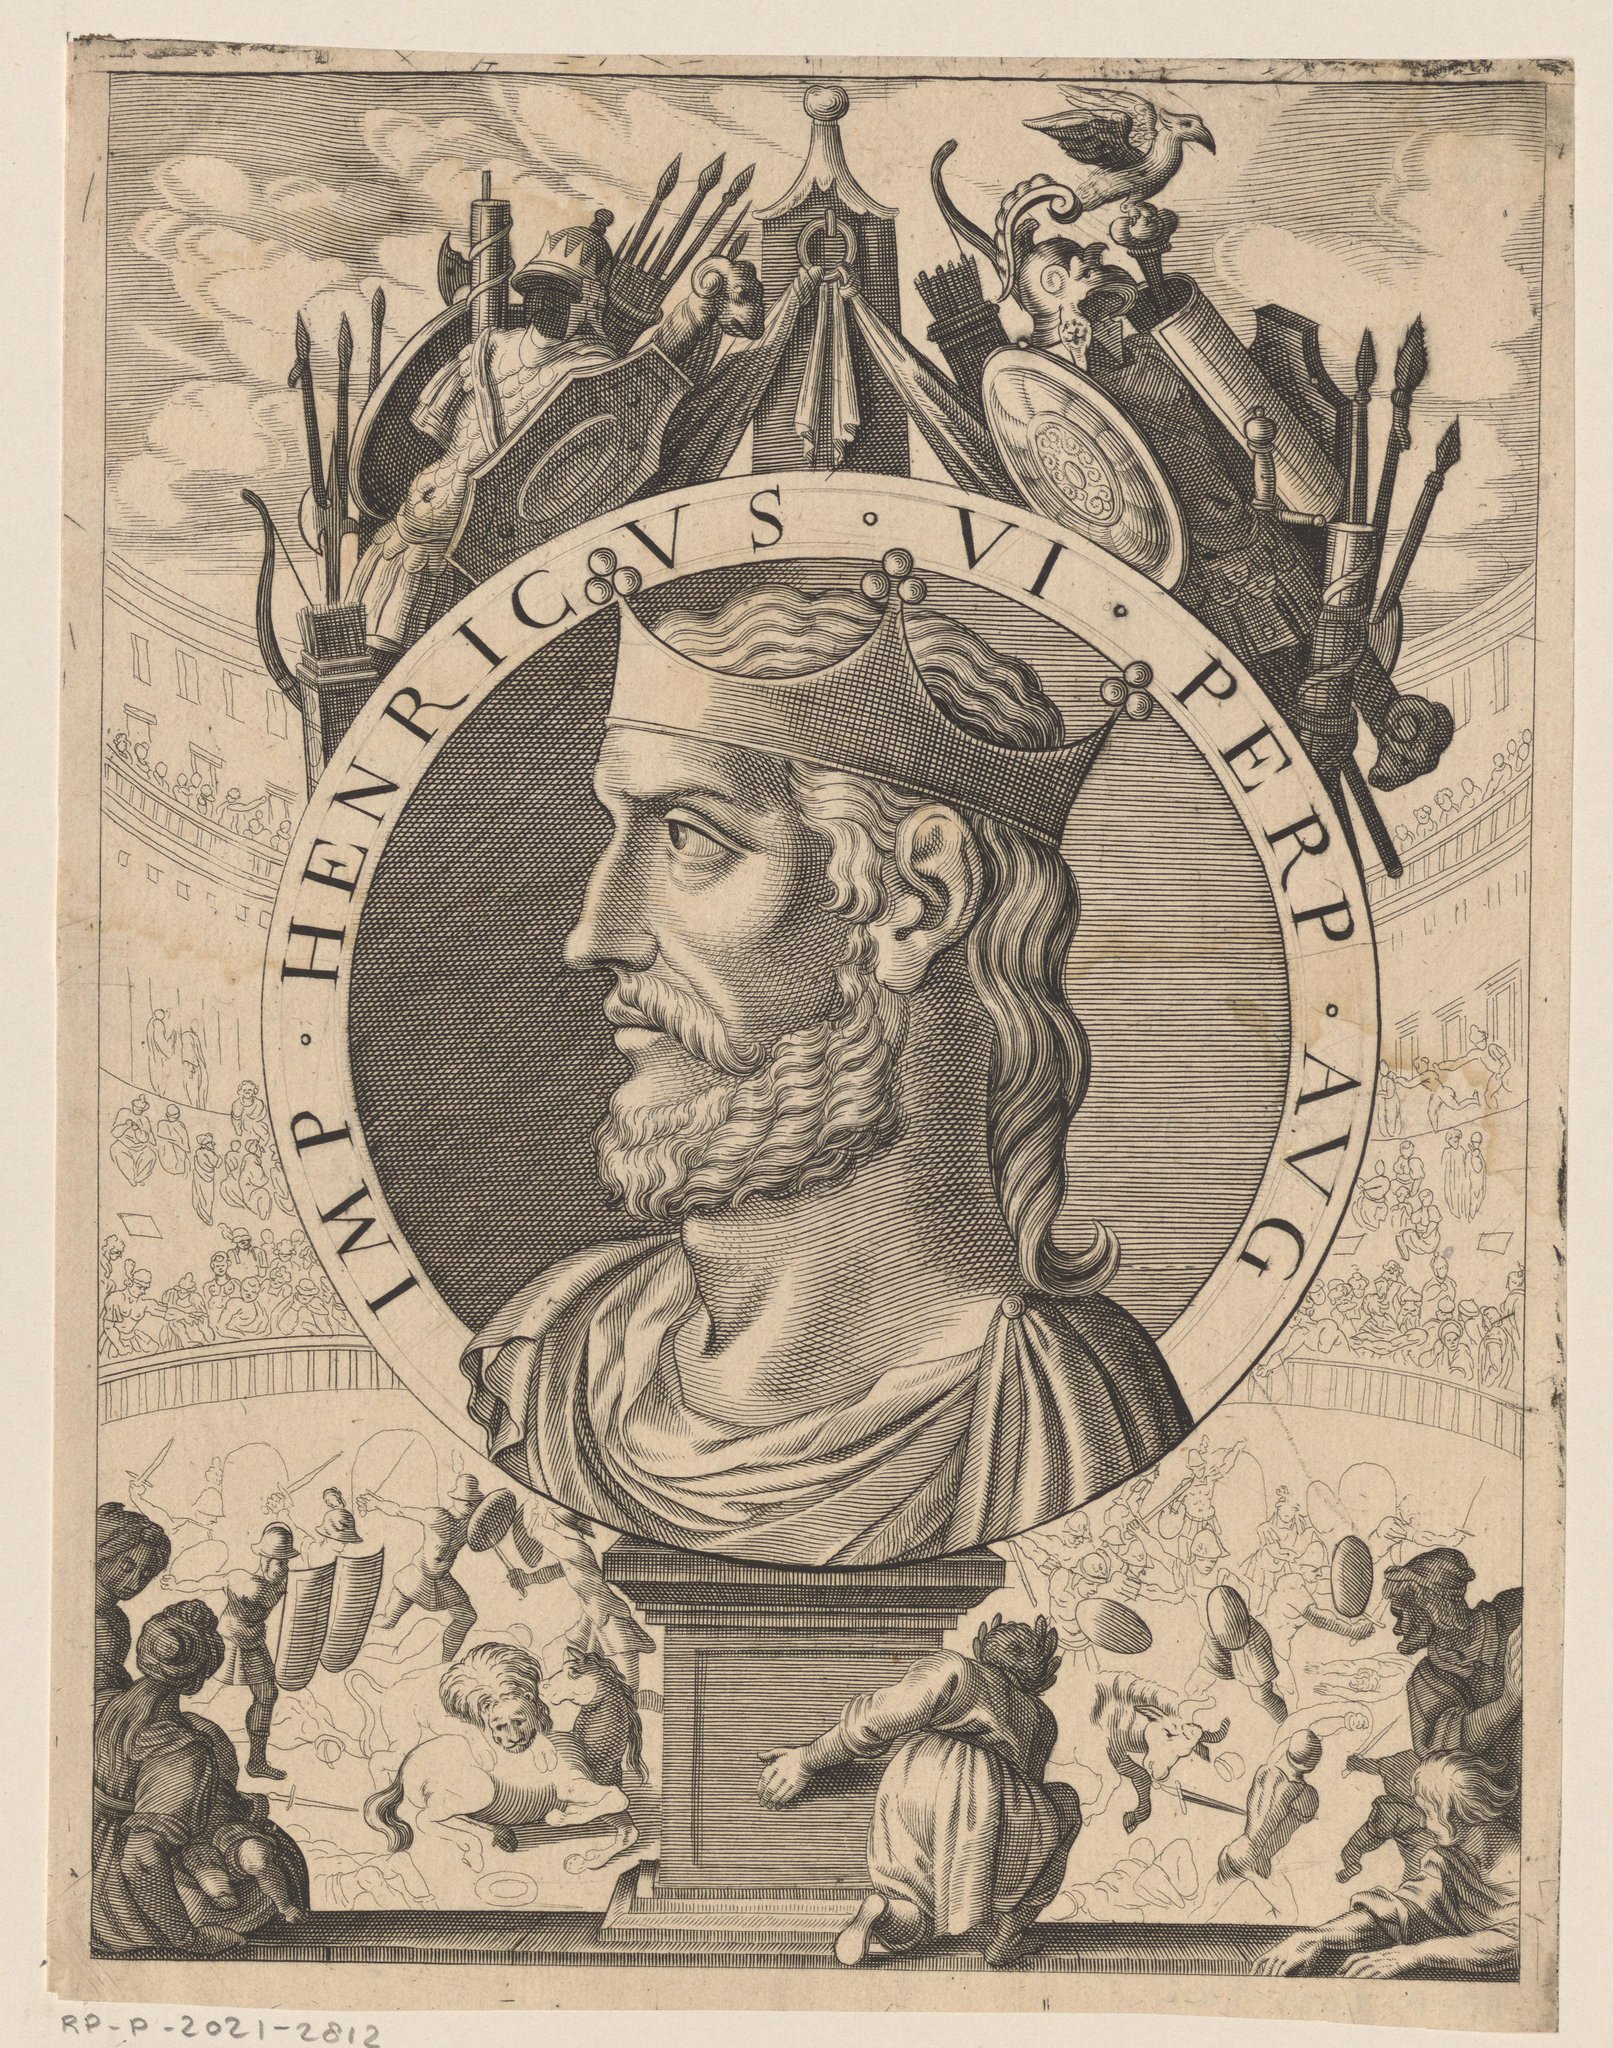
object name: print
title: Portret van Hendrik VI, keizer van het Heilige Roomse Rijk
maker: Anonymous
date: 1700-1799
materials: paper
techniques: engraving, etching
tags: nijmegen, fight between man and animal, historical persons, weapons, emperor